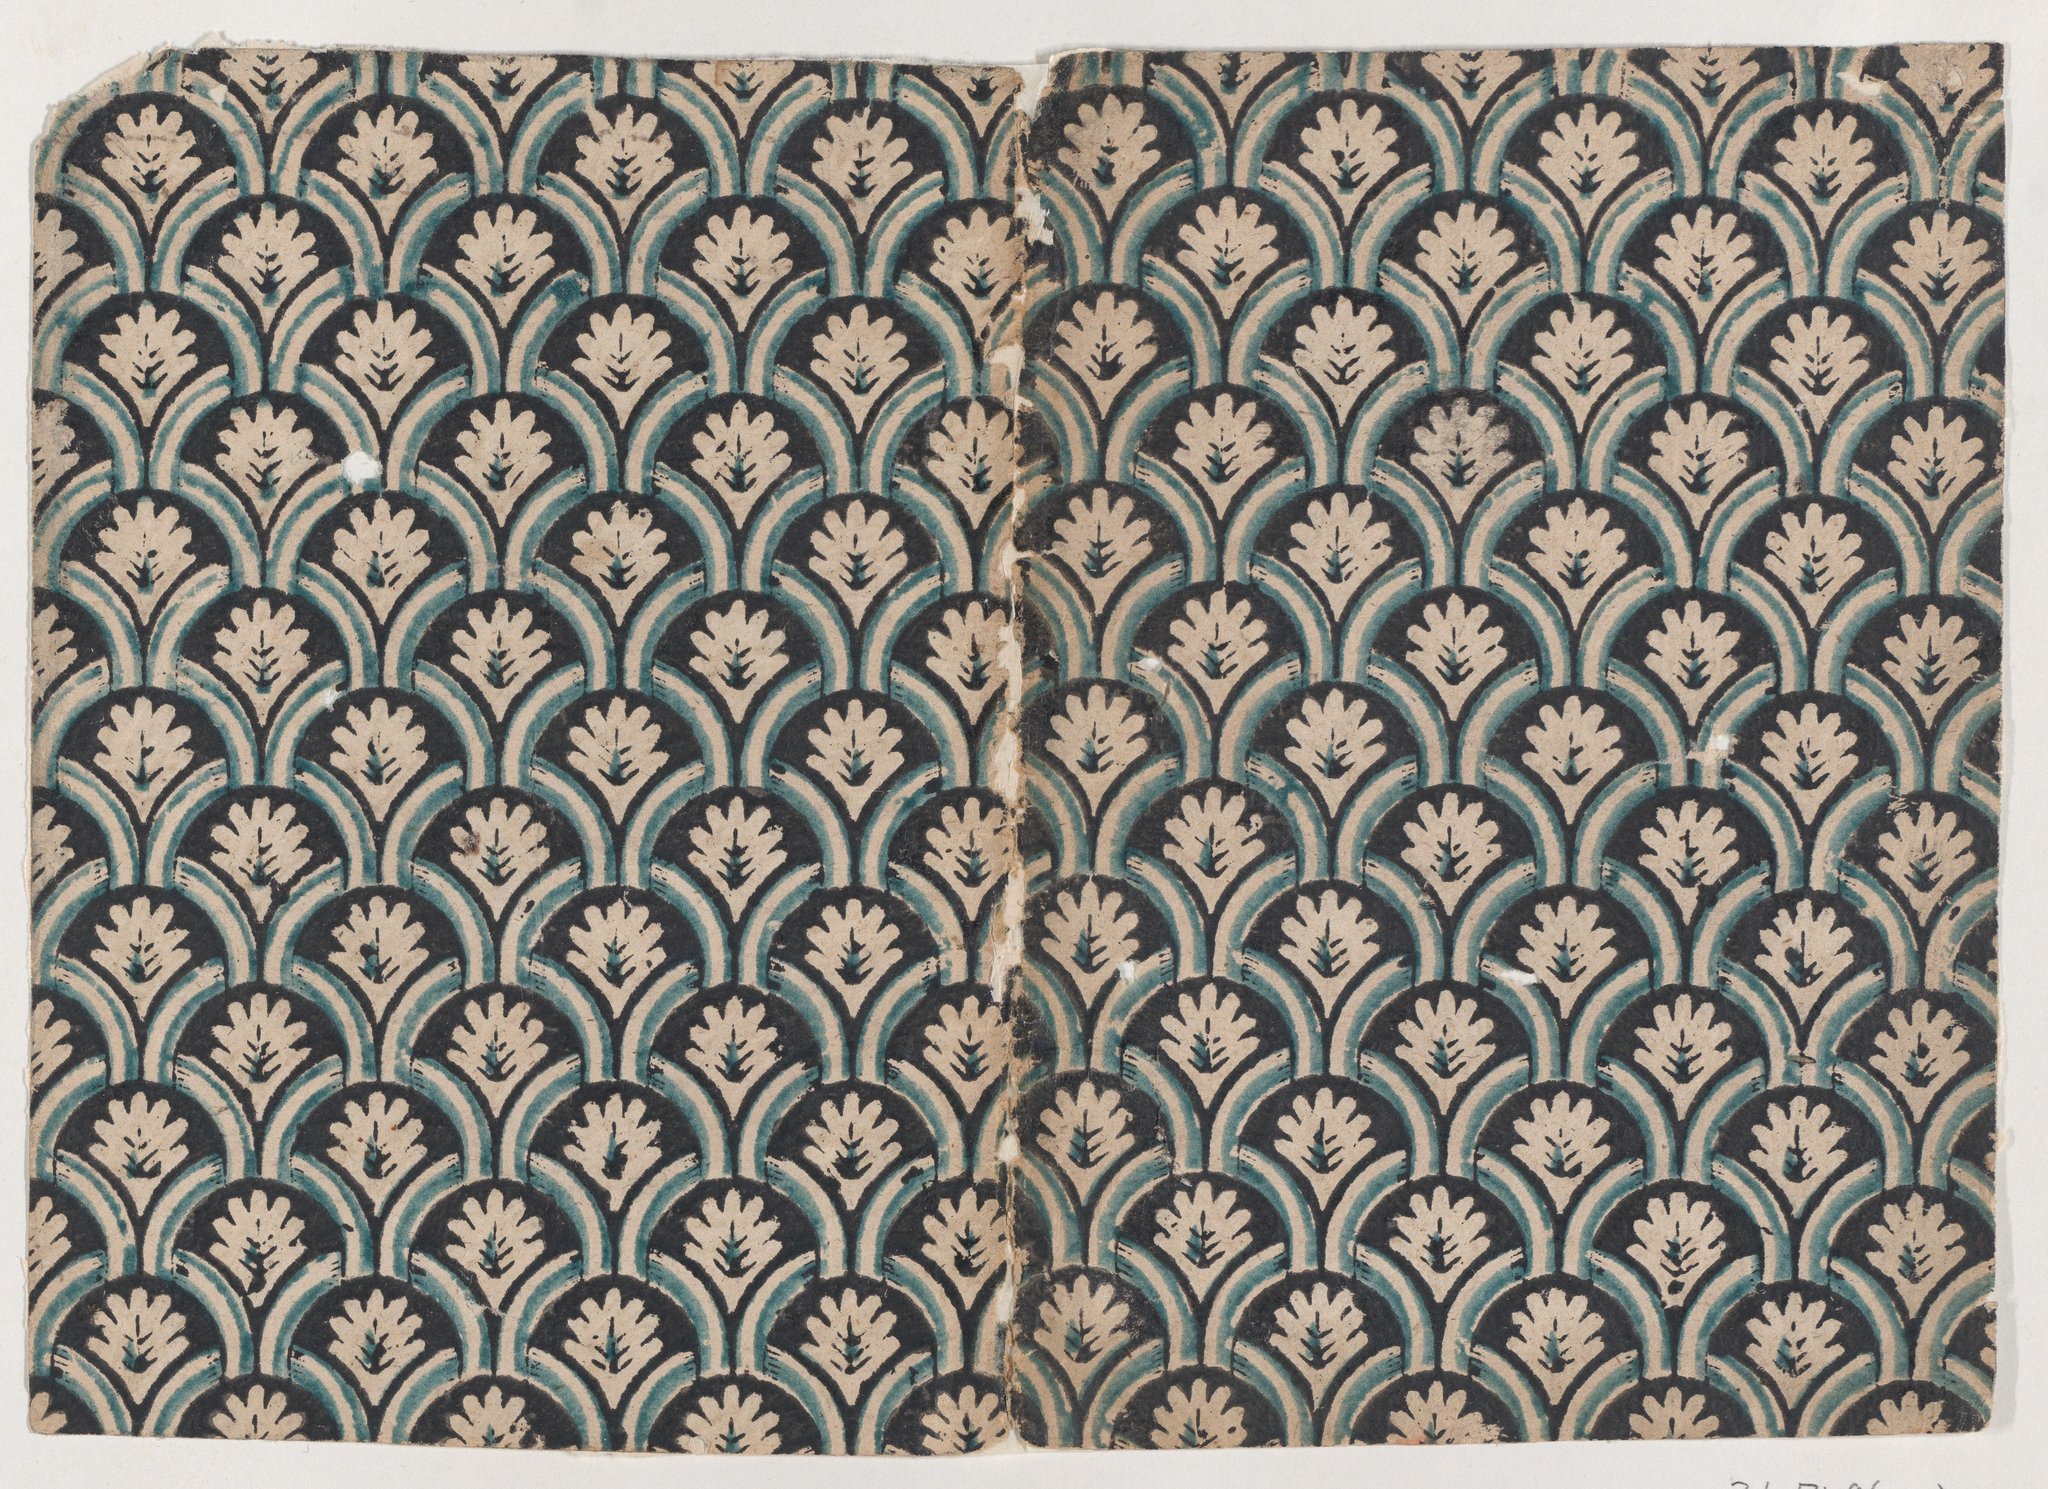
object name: print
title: Decorative Paper with an Overall Scallop and Palmette Pattern in Black and Blue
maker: anonymous, french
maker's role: artist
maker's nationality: french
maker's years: 1400-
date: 1780-1840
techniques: relief print